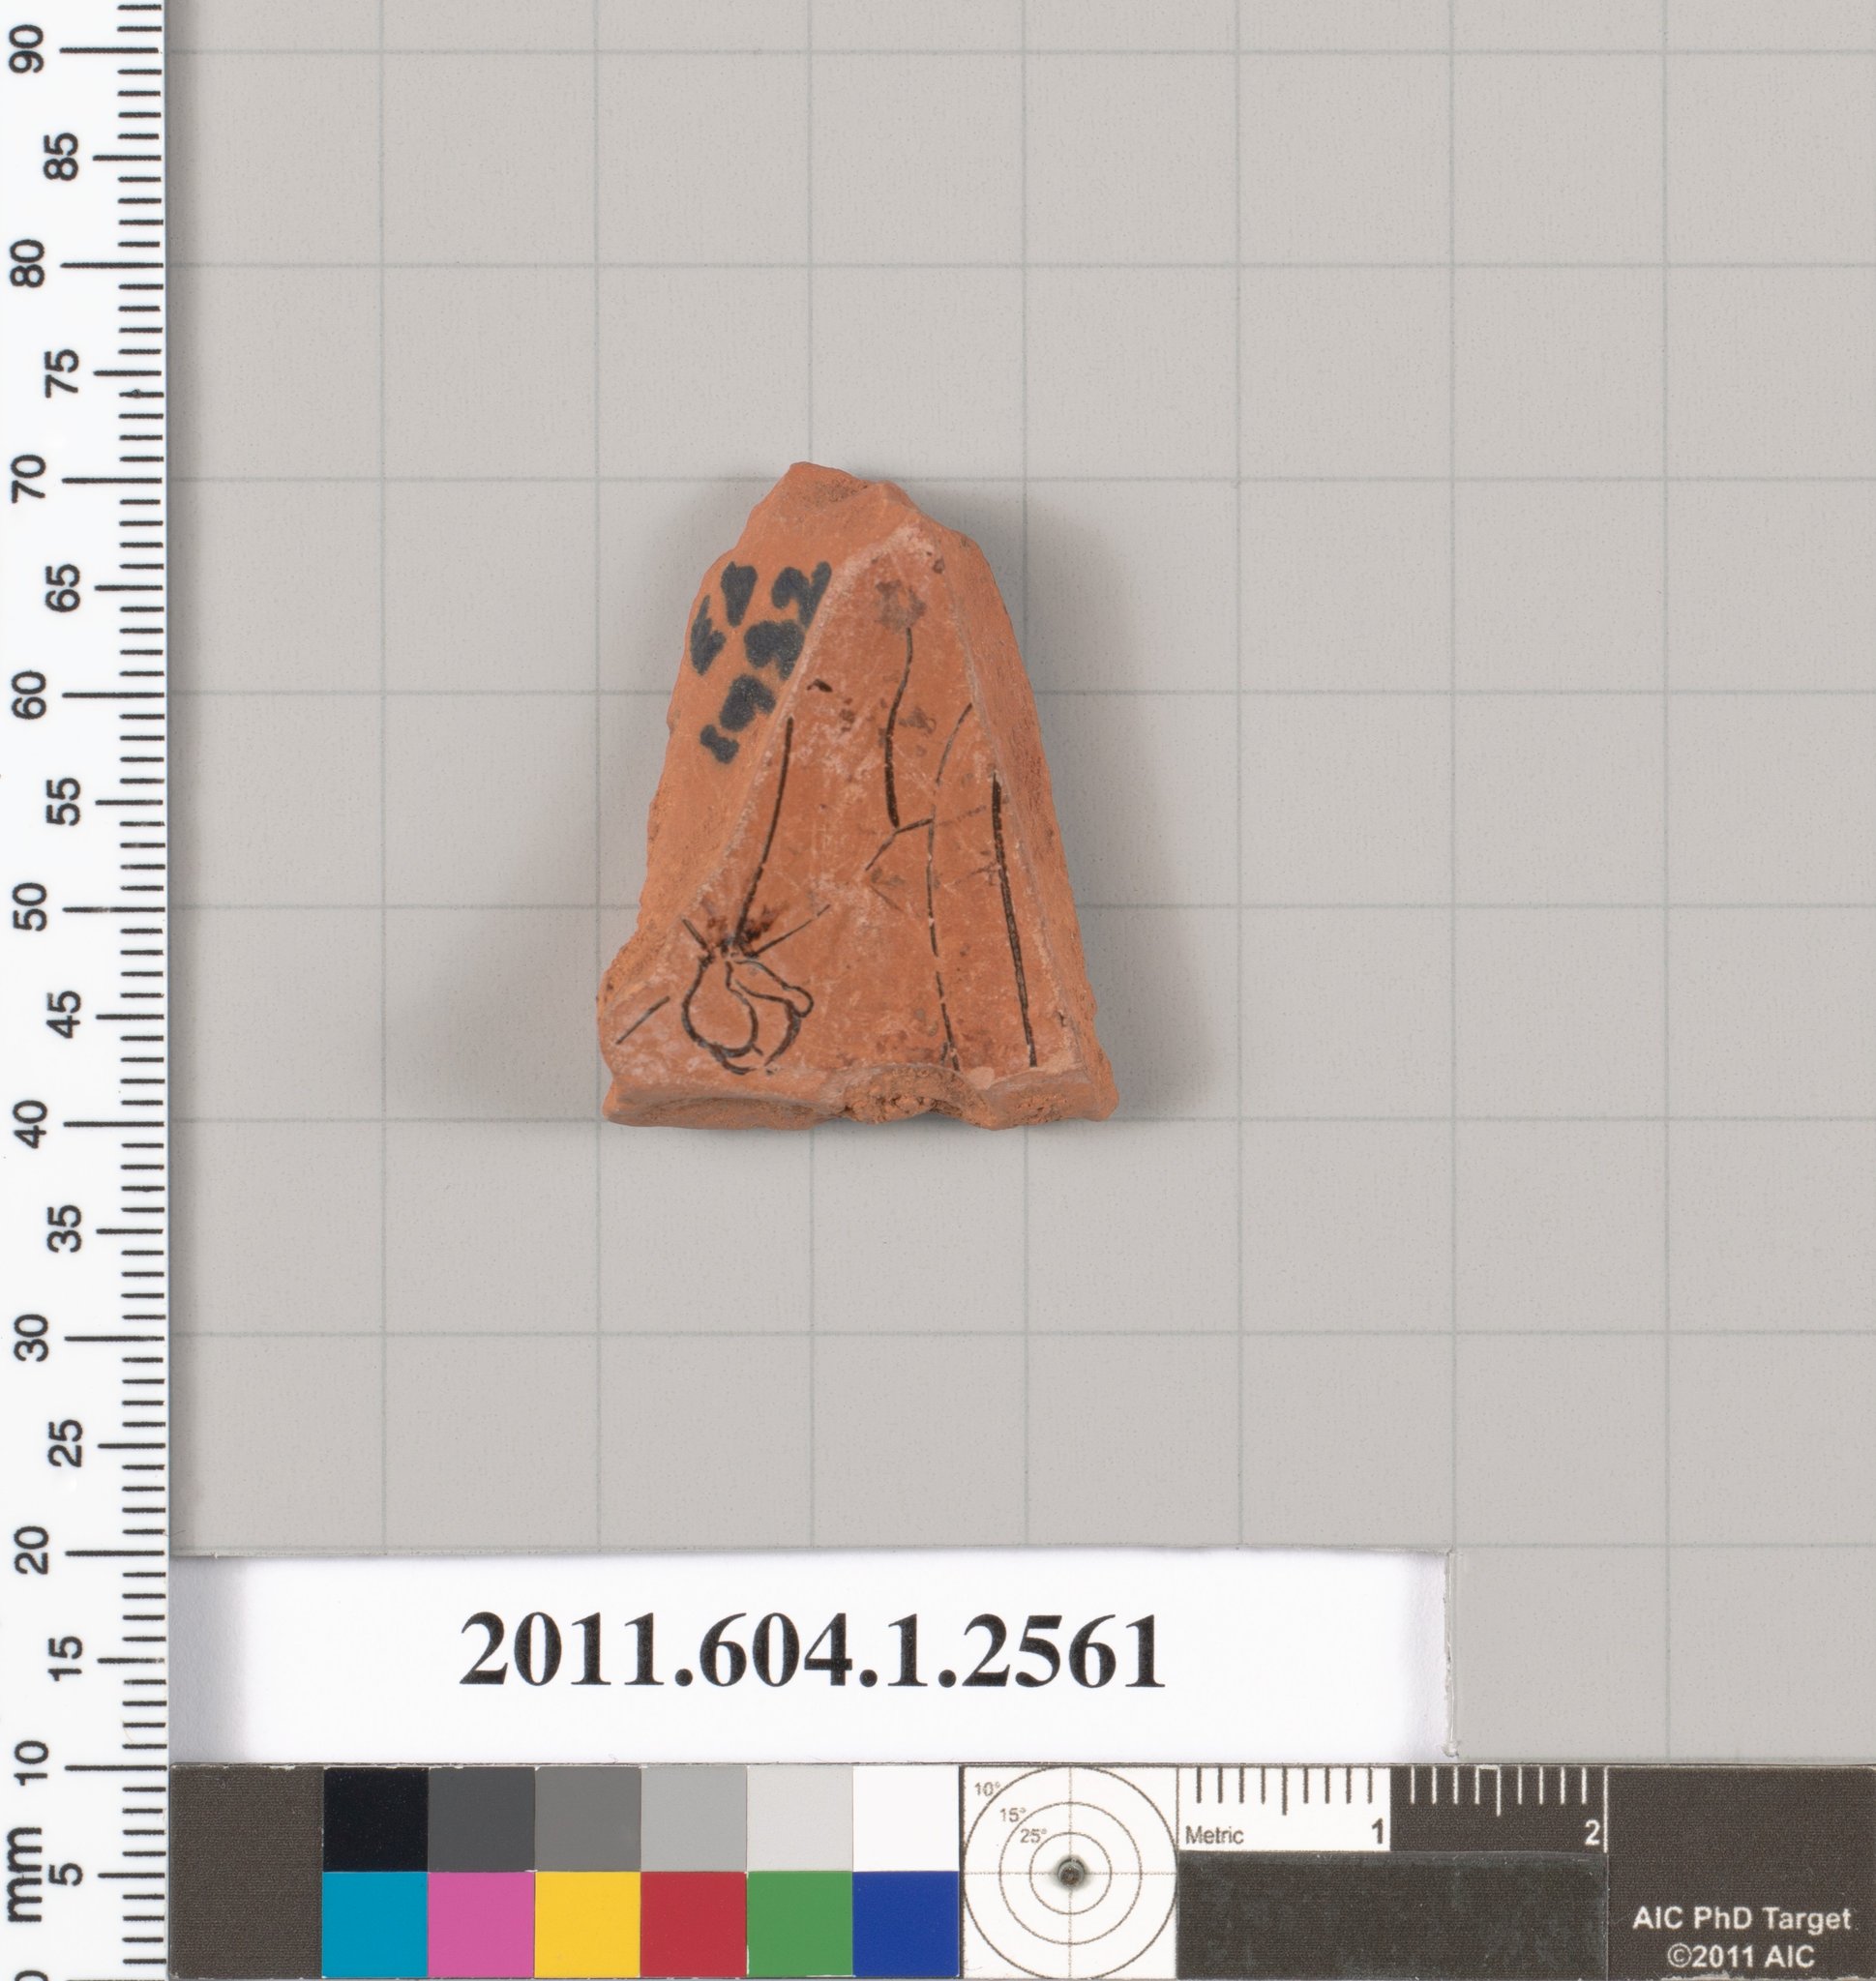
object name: kylix fragment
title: Terracotta fragment of a kylix (drinking cup)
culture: greek, attic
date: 500-476 BCE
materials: terracotta